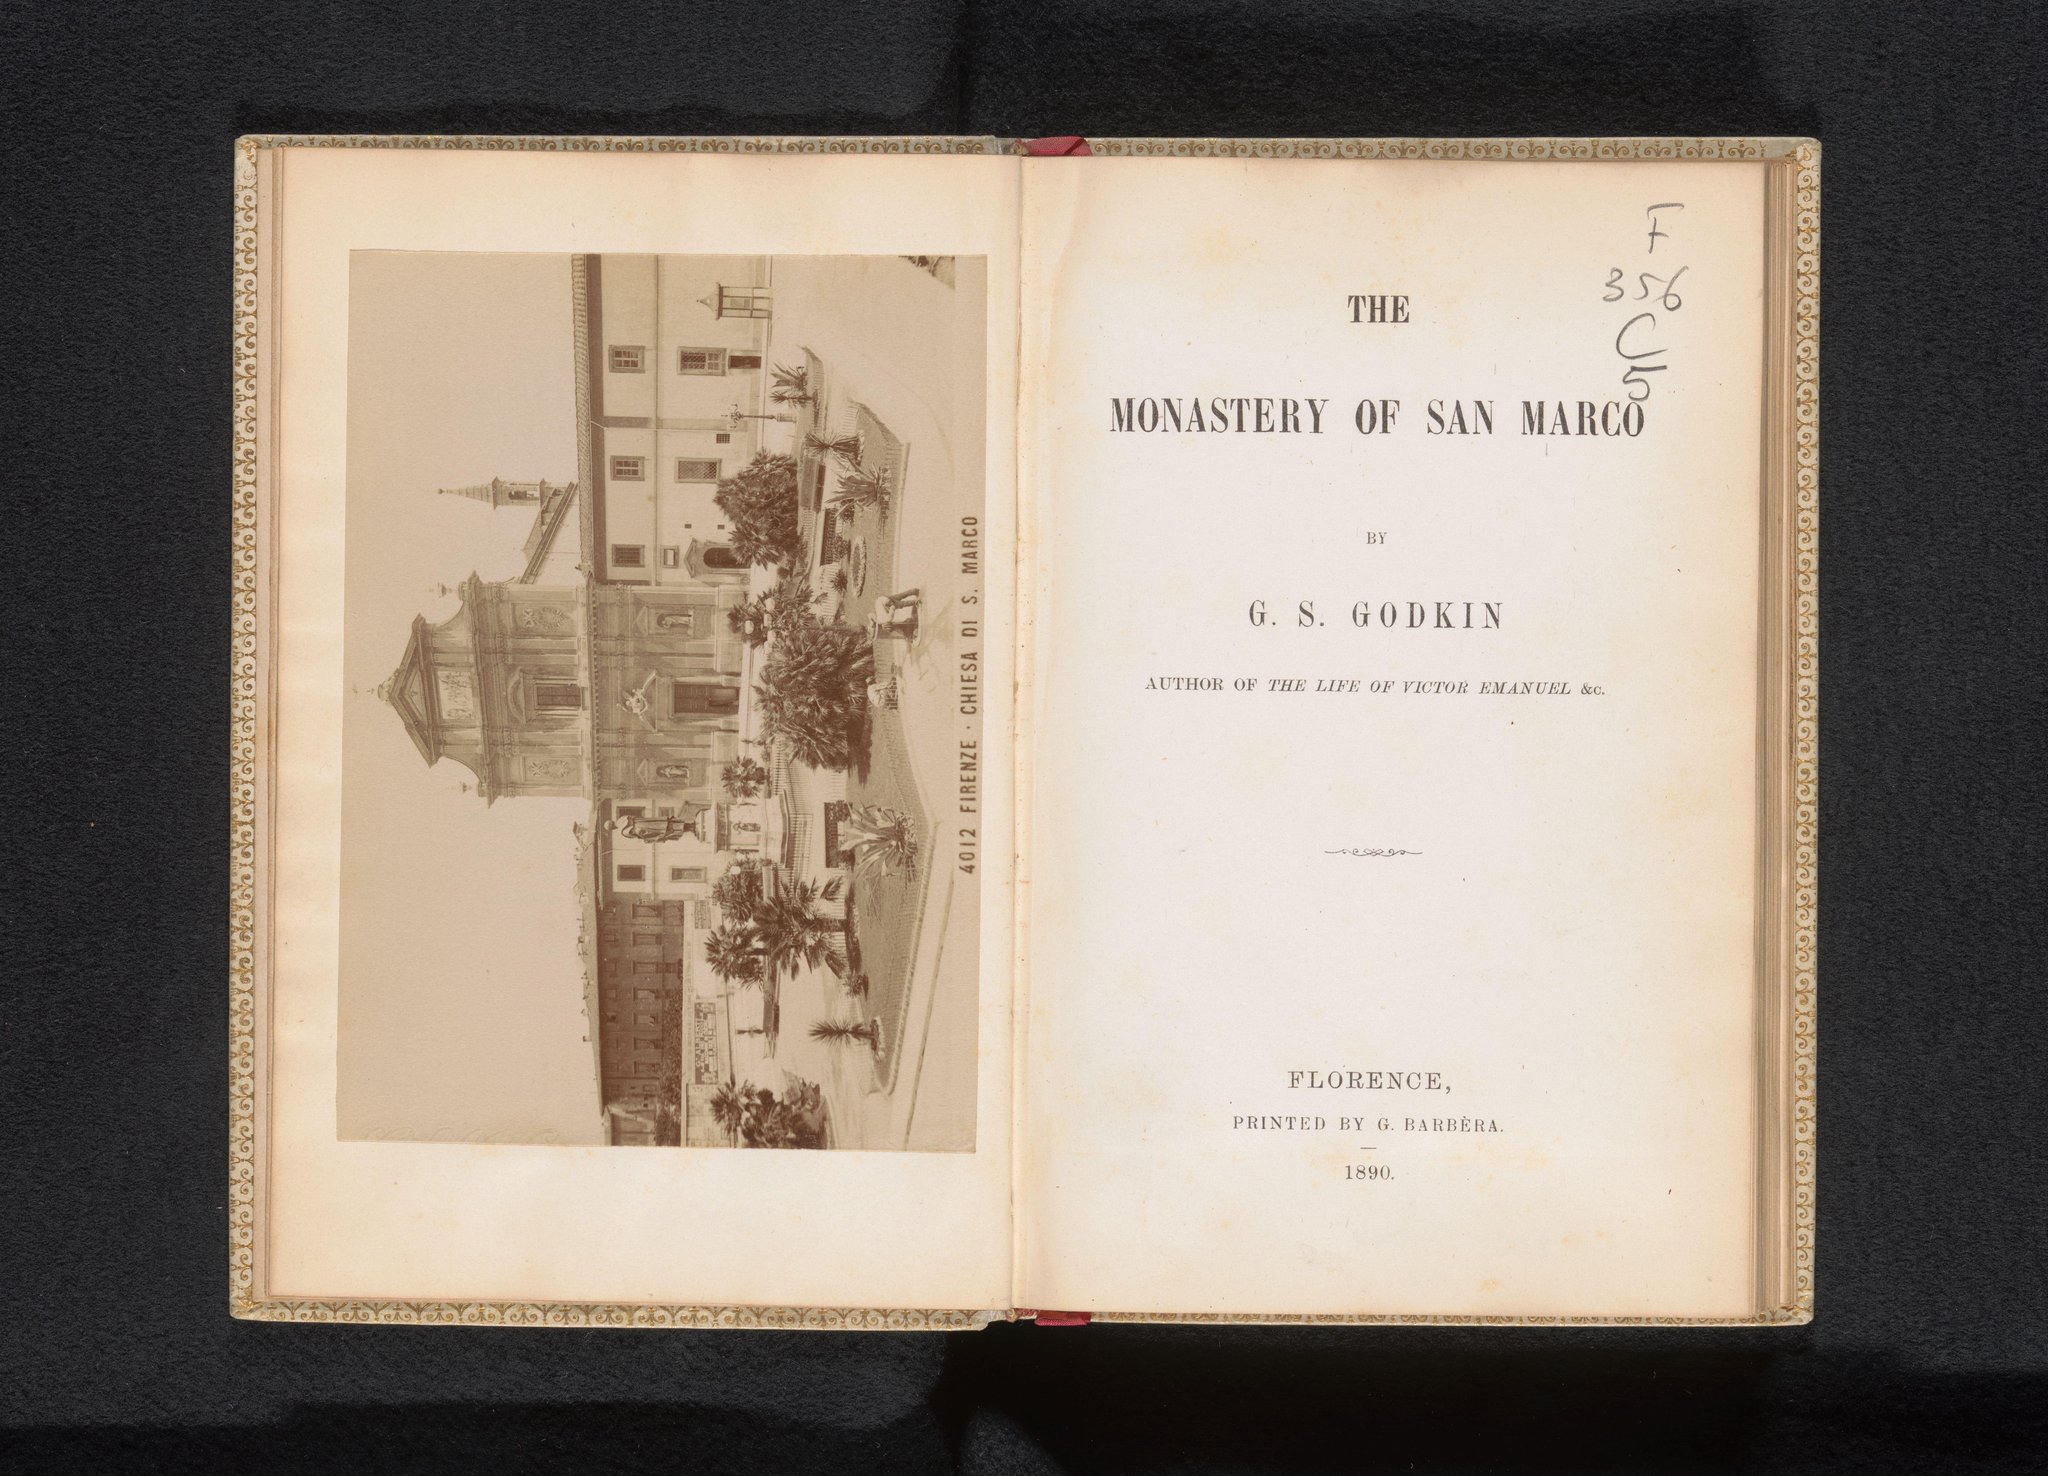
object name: book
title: The monastery of San Marco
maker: georgina sarah godkin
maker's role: auteur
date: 1890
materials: cardboard, paper, photographic support, parchment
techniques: albumen print, printing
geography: florence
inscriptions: inscription: ‘G Giannini books binder Florence Piazza Pitti 19.20.’, inscription: ‘ex libris SFJ’